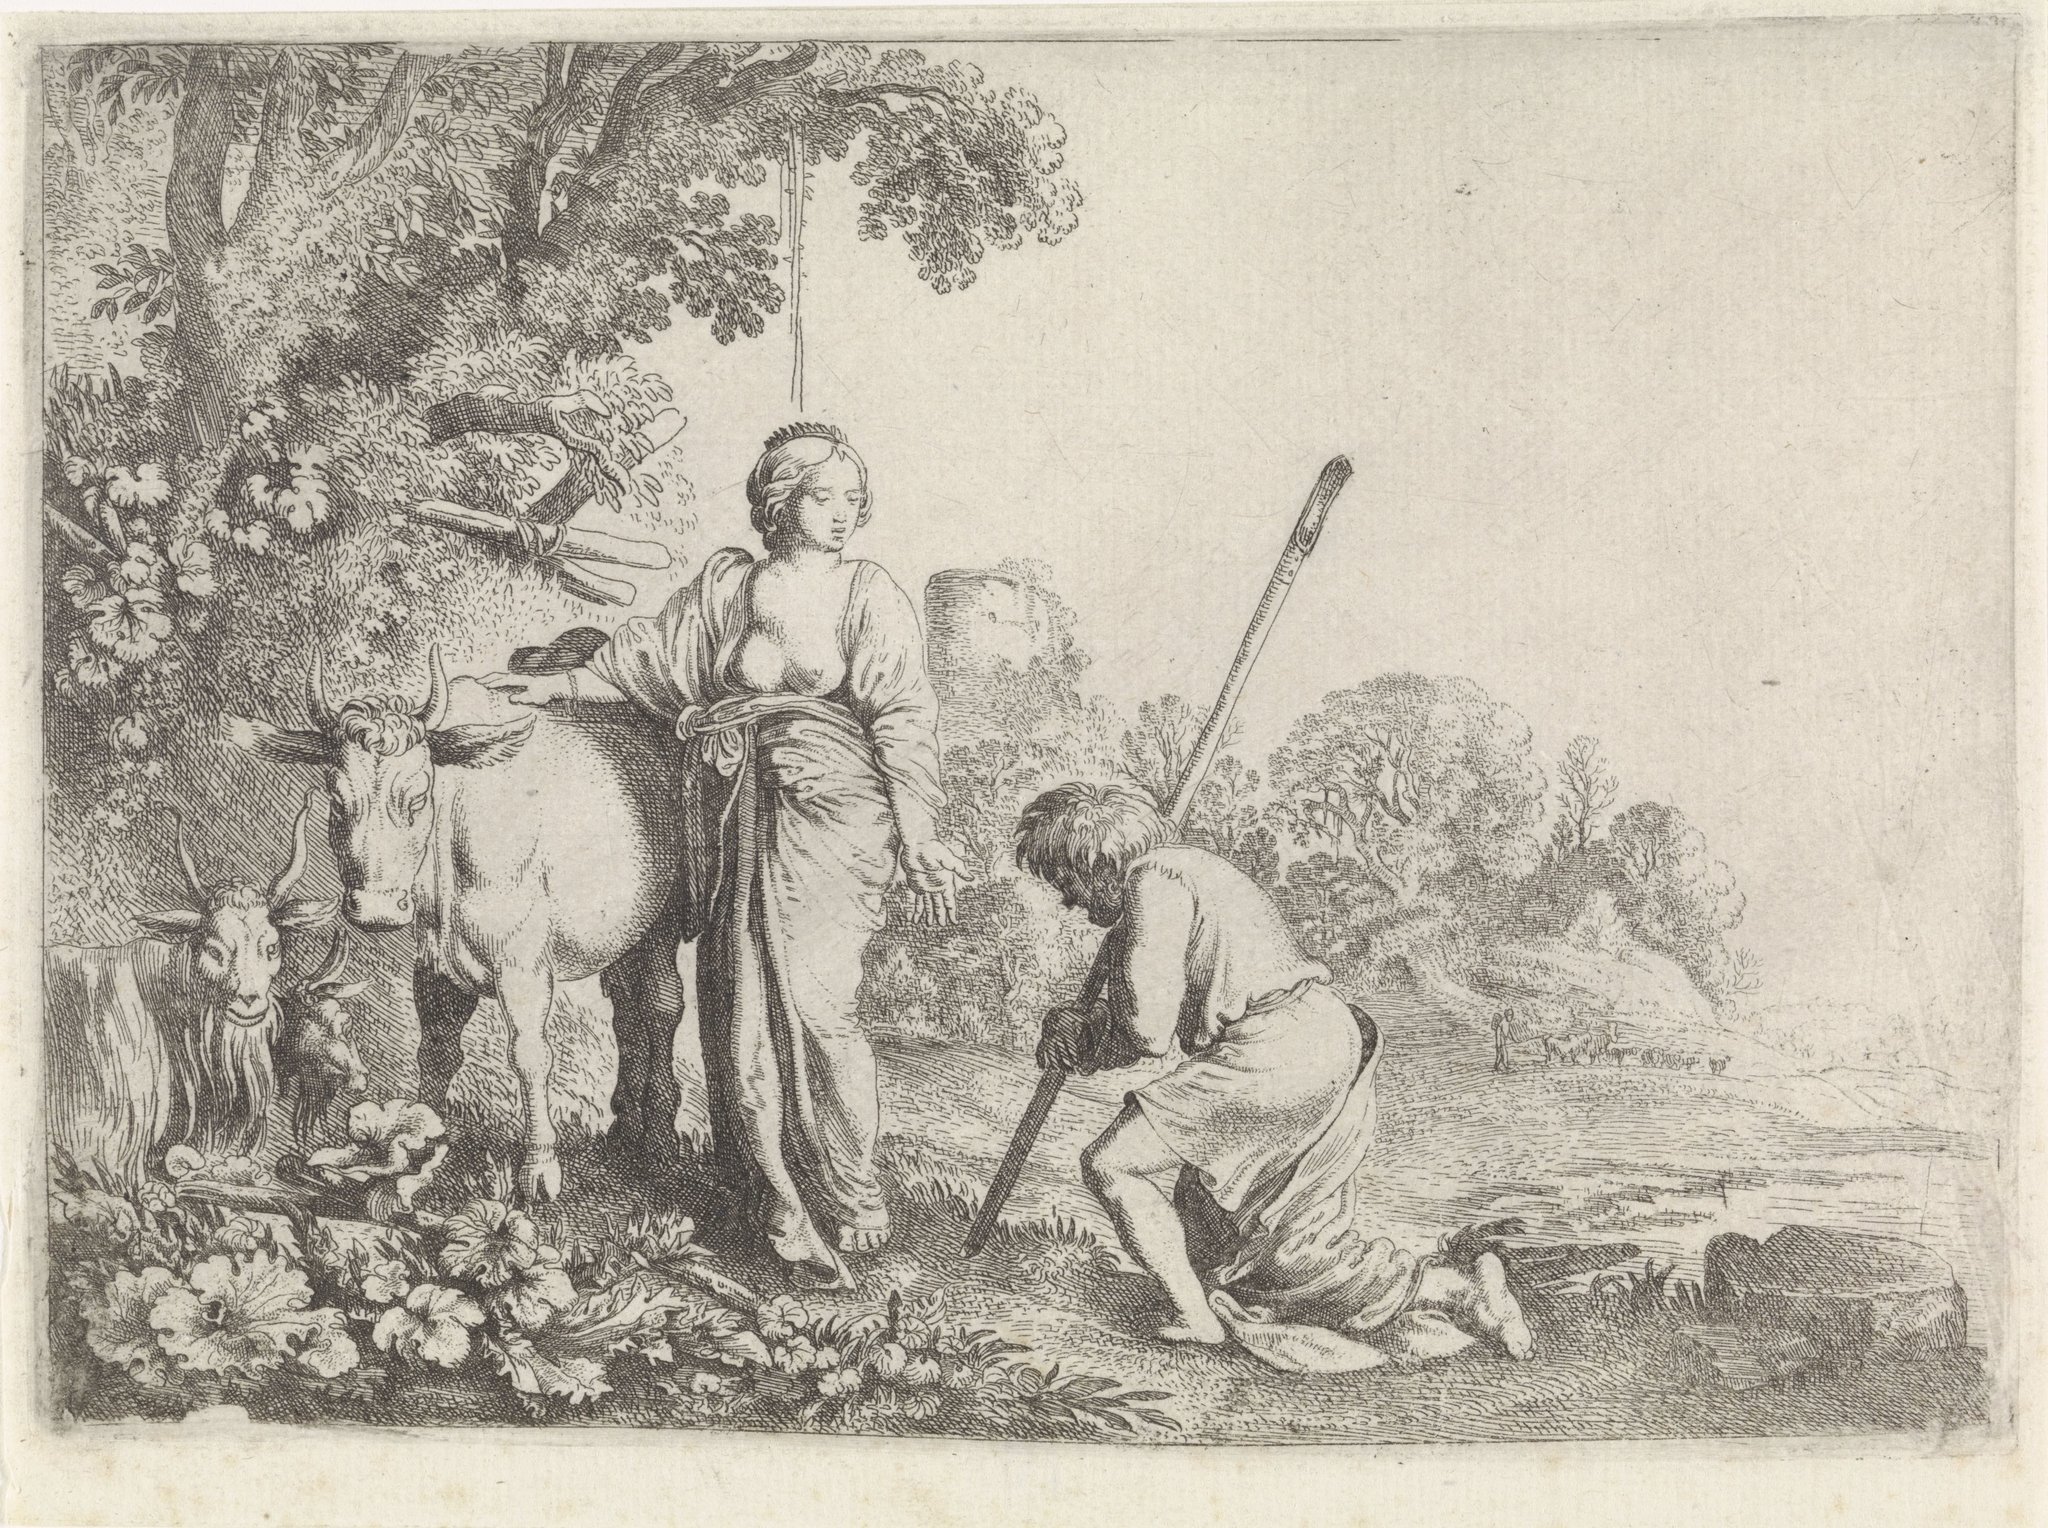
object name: print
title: Mercurius en Argus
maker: moyses van wtenbrouck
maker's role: painter, print maker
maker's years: 1590-1647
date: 1618-1628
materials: paper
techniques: engraving, etching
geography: the hague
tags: io is petted by inachus, her father, and by her sisters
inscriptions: collector's mark: Lugt 240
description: Juno laat de koe (Io) bewaken door de reus Argus. Argus knielt voor Juno. Scène uit Ovidius’ Metamorfosen (Met. I, 624).